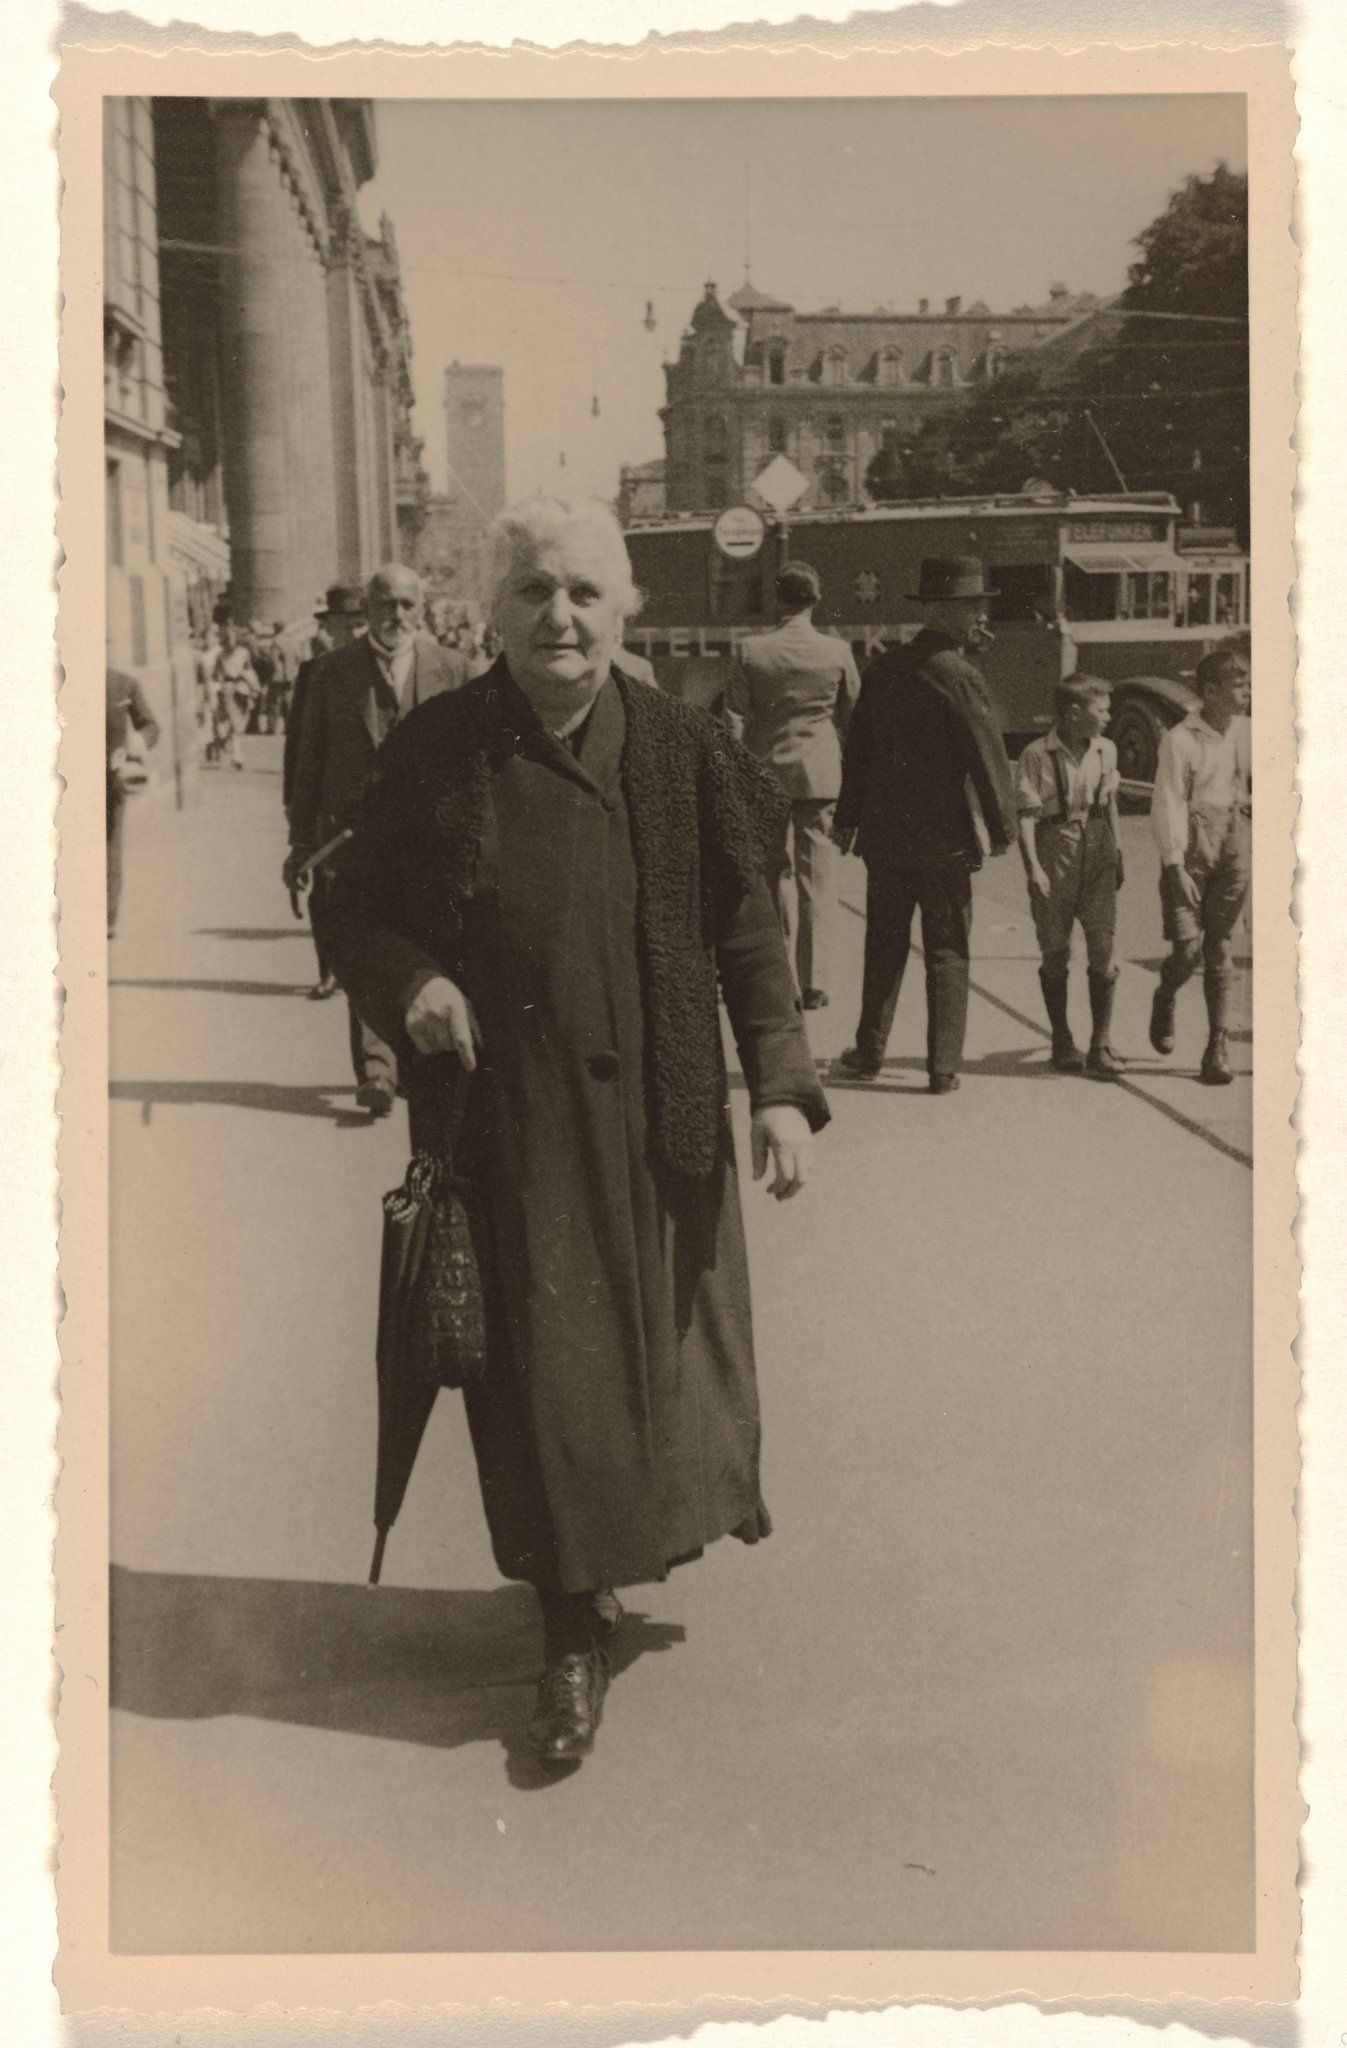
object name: photograph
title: Tante Lenchen in donkere kleding met paraplu in haar hand en een kleed om haar schouders geslagen, lopend over straat met mensen, gebouwen voertuigen op de achtergrond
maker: Anonymous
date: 1907-1932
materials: photographic support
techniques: gelatin silver print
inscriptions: date: ‘Tante Lenchen Juli 1932 (74 Jahre)’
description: Tante Lenchen in donkere kleding met paraplu in haar hand en een kleed om haar schouders geslagen, lopend over straat met mensen, gebouwen voertuigen op de achtergrond.